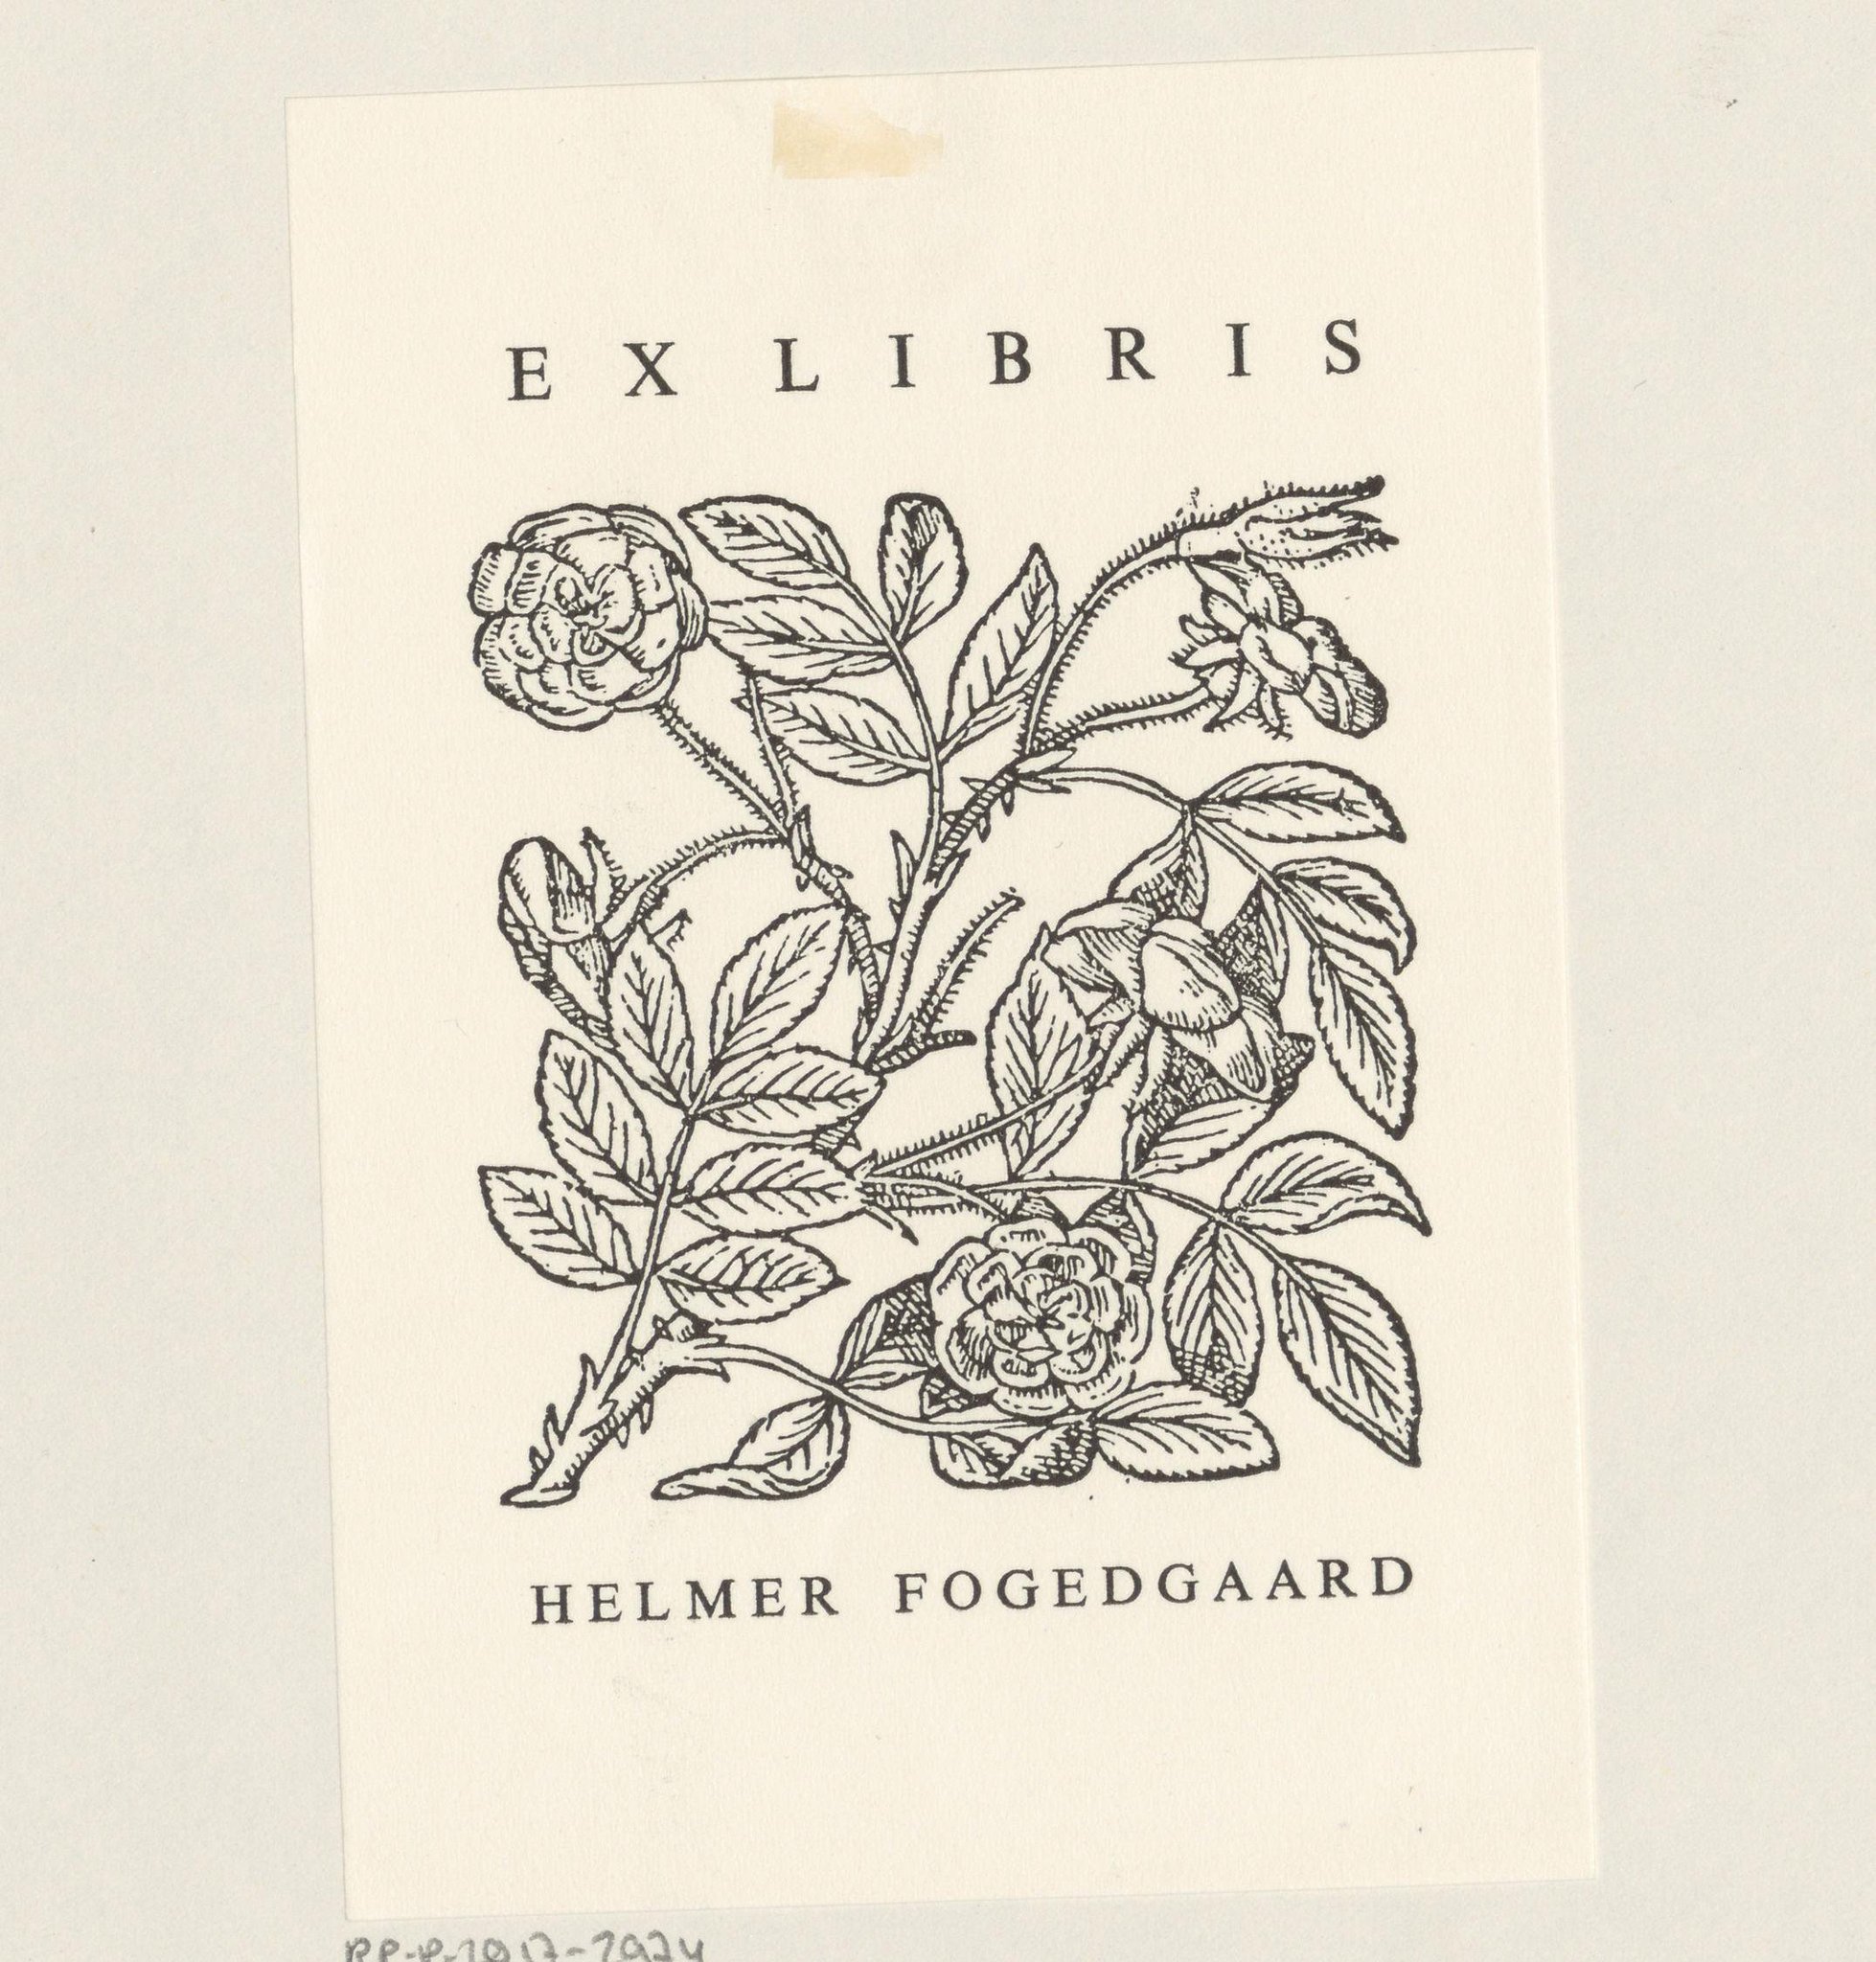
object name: bookplate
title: Ex libris van Helmer Fogedgaard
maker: Anonymous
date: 1917-2002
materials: paper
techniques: printing block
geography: denmark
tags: flowers: rose